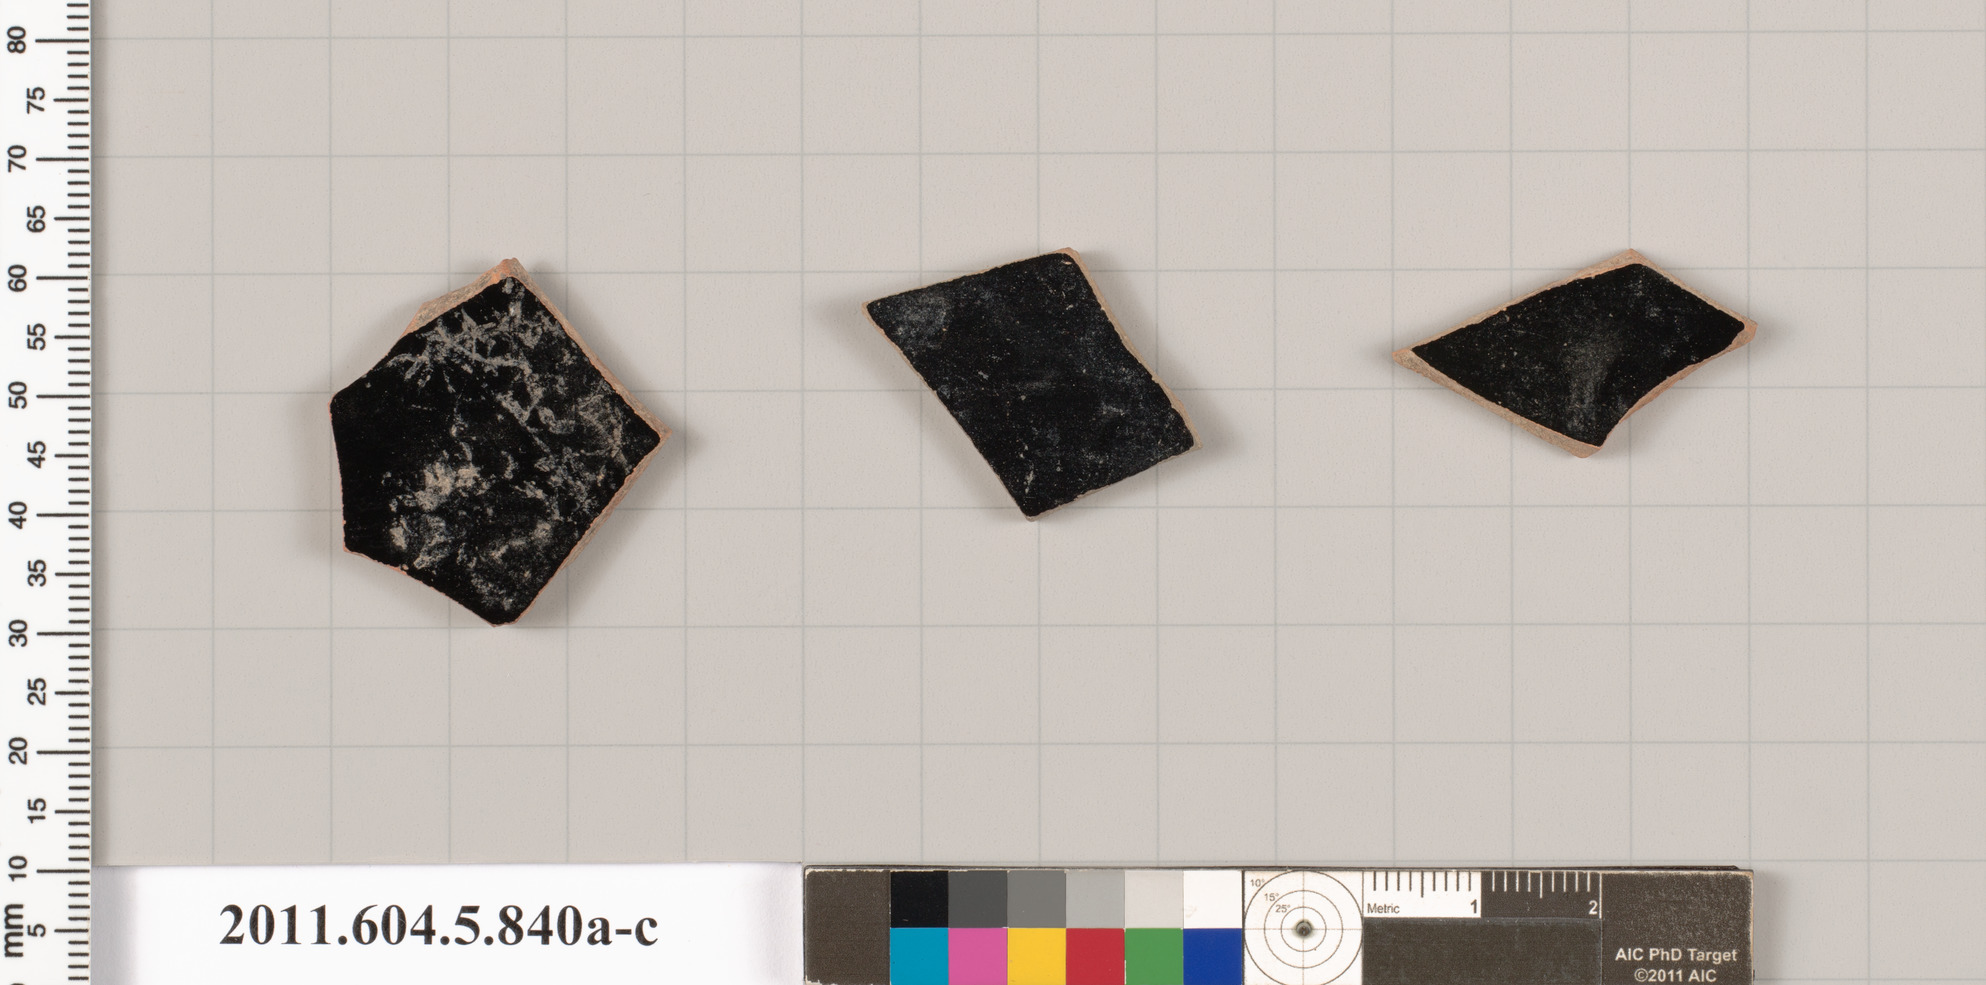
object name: kylix fragment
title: Terracotta fragments of kylikes (drinking cups)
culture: greek, attic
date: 600-401 BCE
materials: terracotta